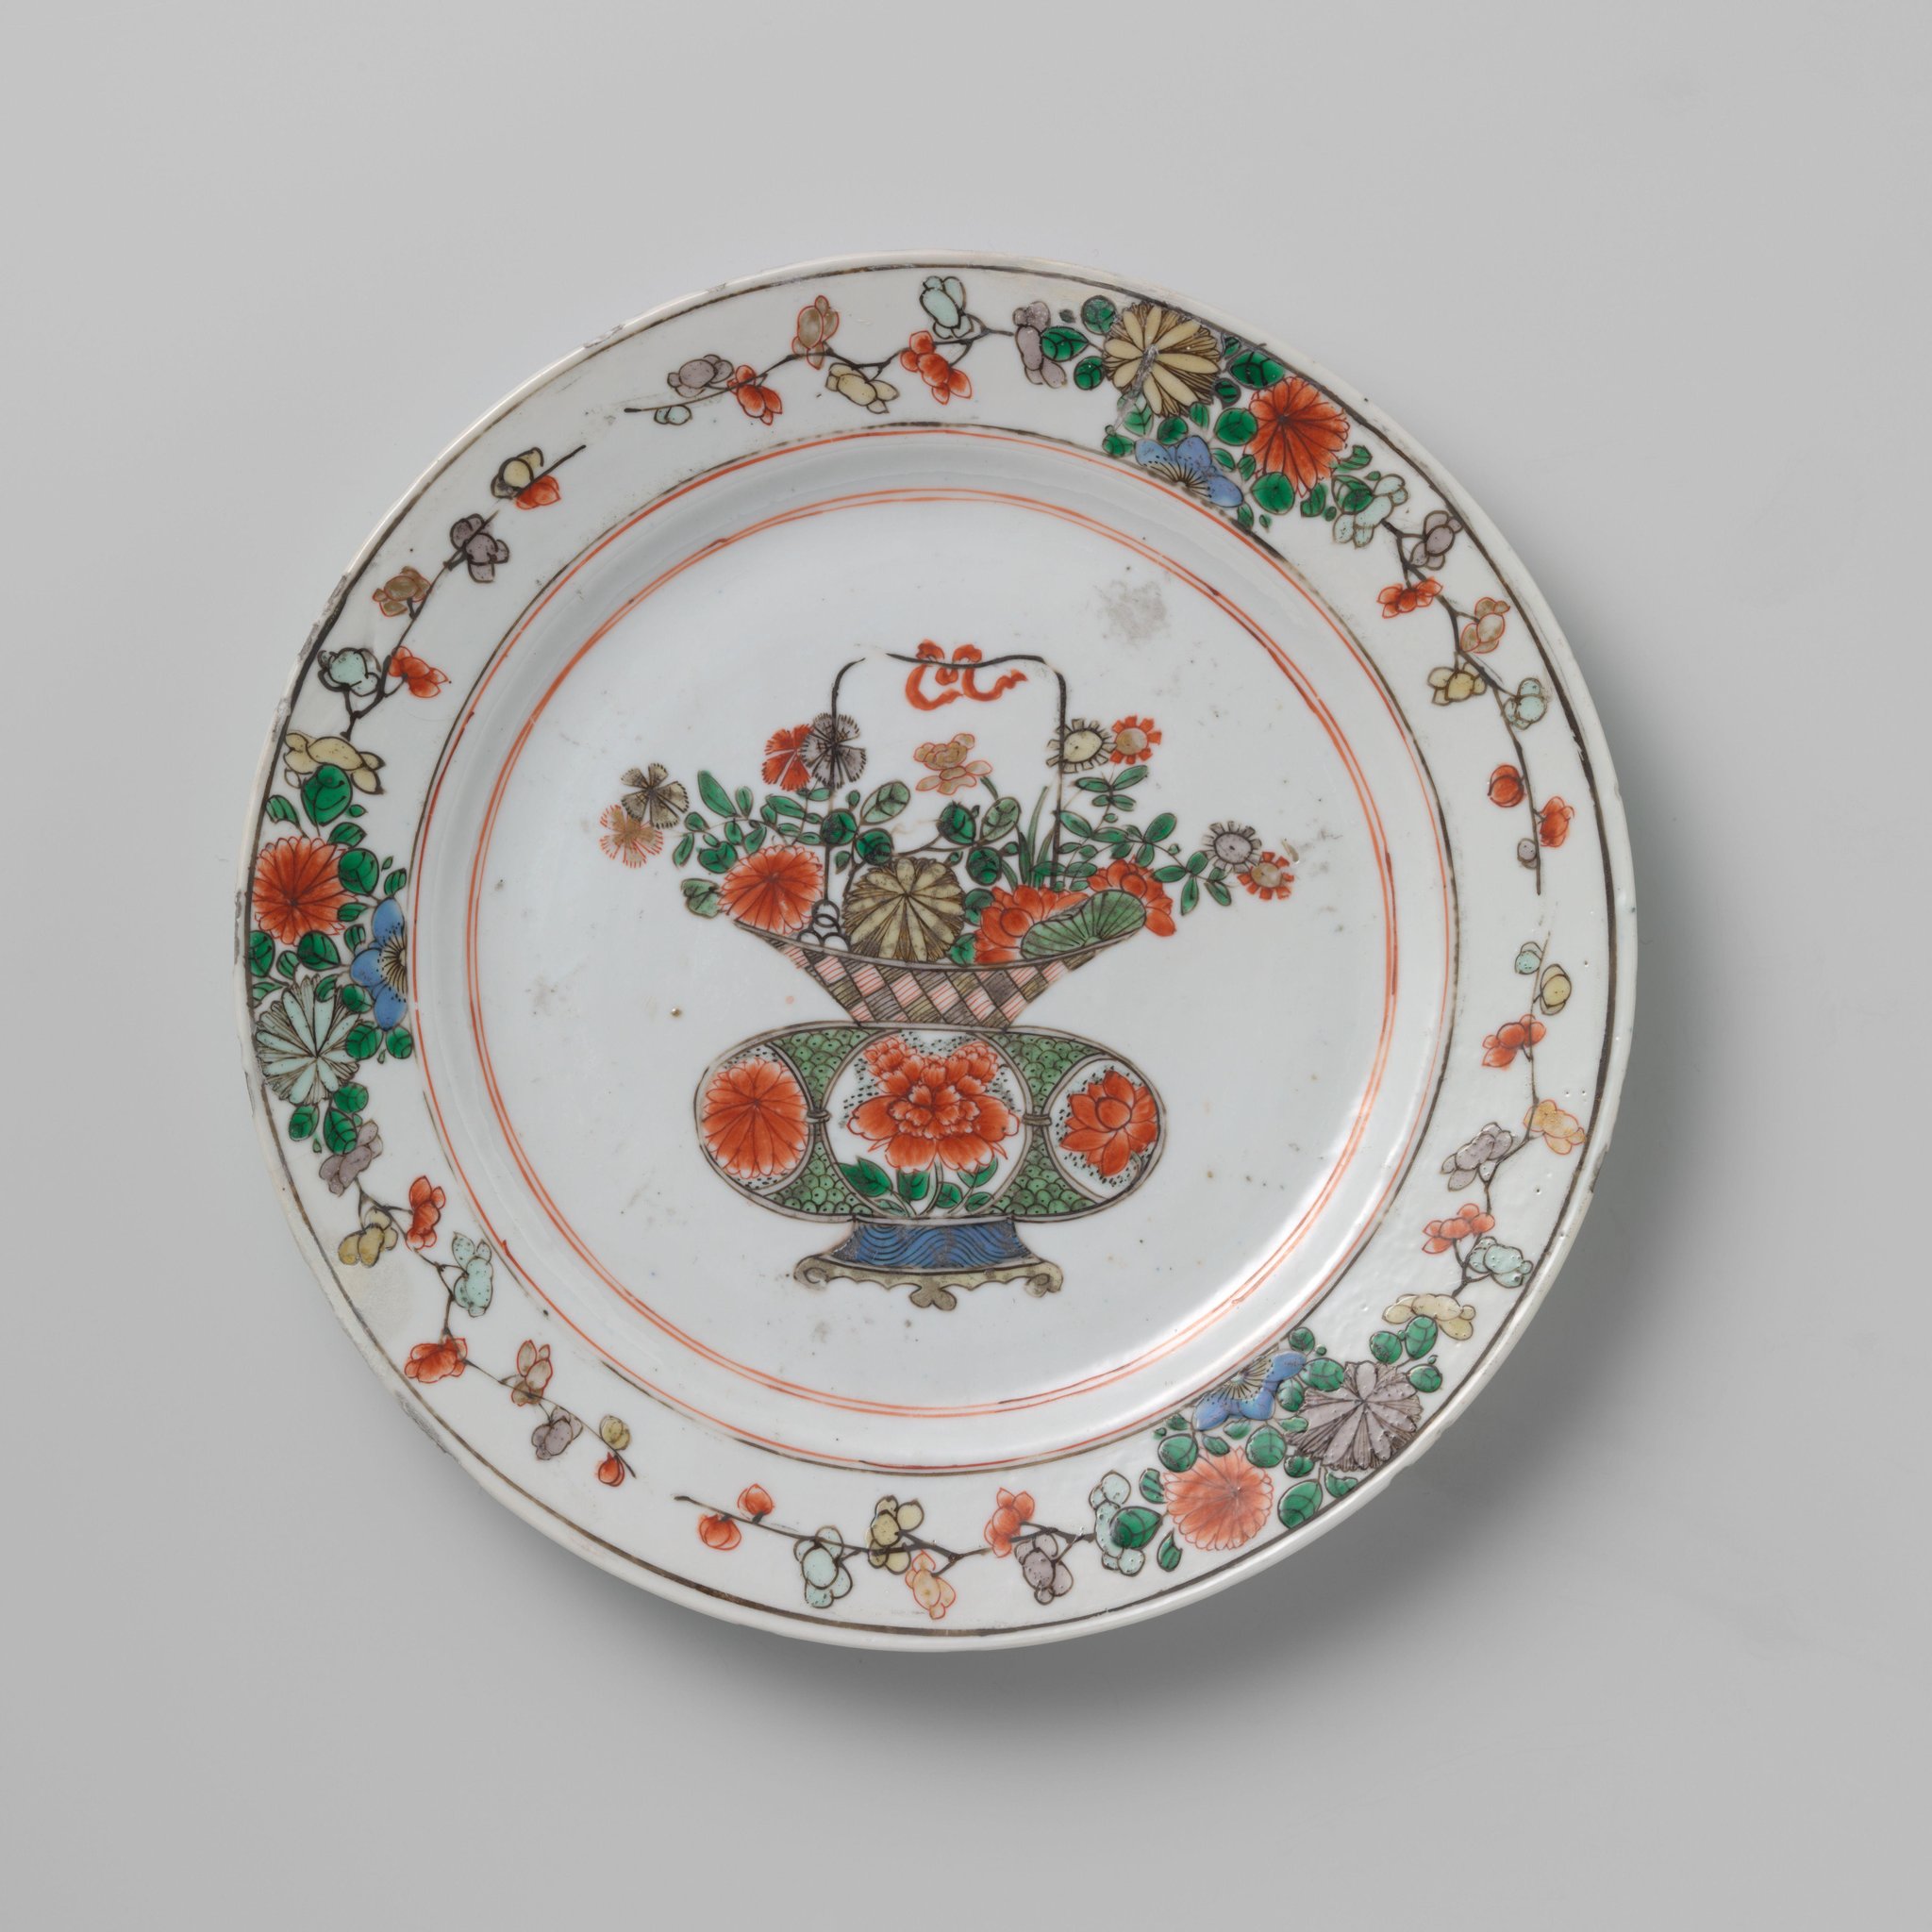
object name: plate dish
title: Plate with flower basket and flower sprays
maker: Anonymous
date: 1700-1724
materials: cobalt, glaze, gold, paint, porcelain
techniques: firing, gilding, turning, vitrification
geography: china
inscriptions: mark